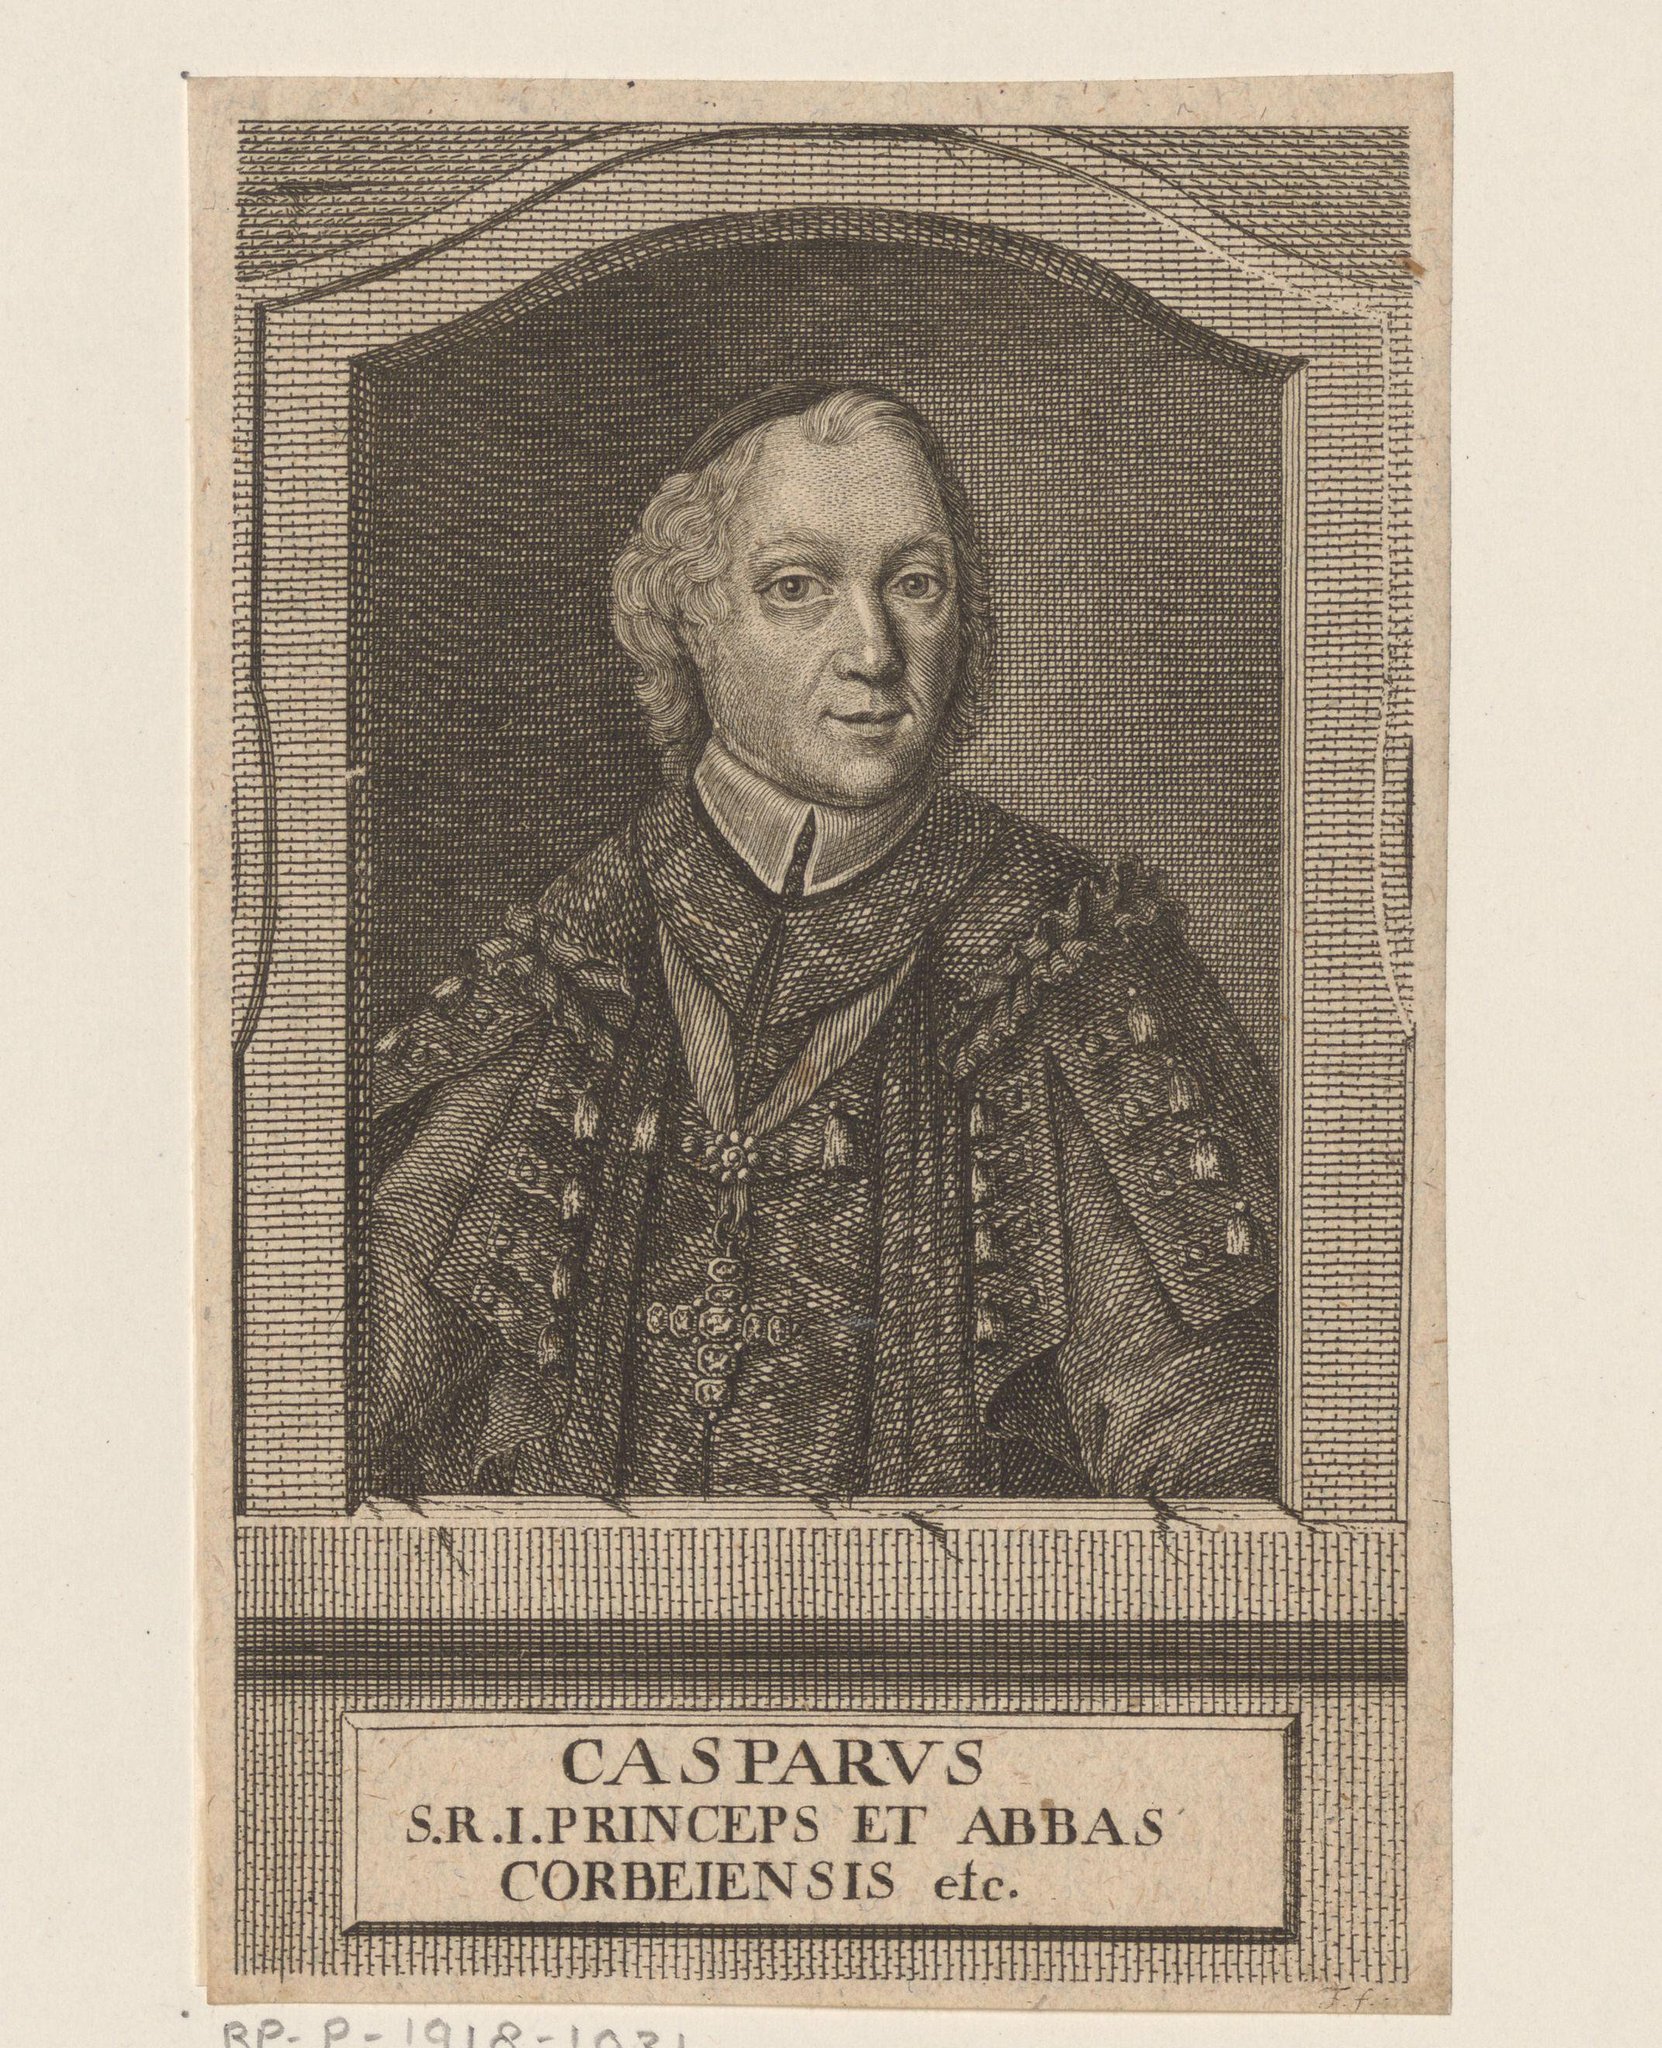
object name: print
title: Portret van Caspar von Böselager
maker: Anonymous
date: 1750-1760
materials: paper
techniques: engraving, etching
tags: abbot, historical persons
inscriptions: collector's mark: Lugt 2233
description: Prent mogelijk uit: Die Neue Europäische Fama, Welche den gegenwärtigen Zustand der vornehmsten Höfe entdecket. S.l.s.n., 1753, dl. 188.